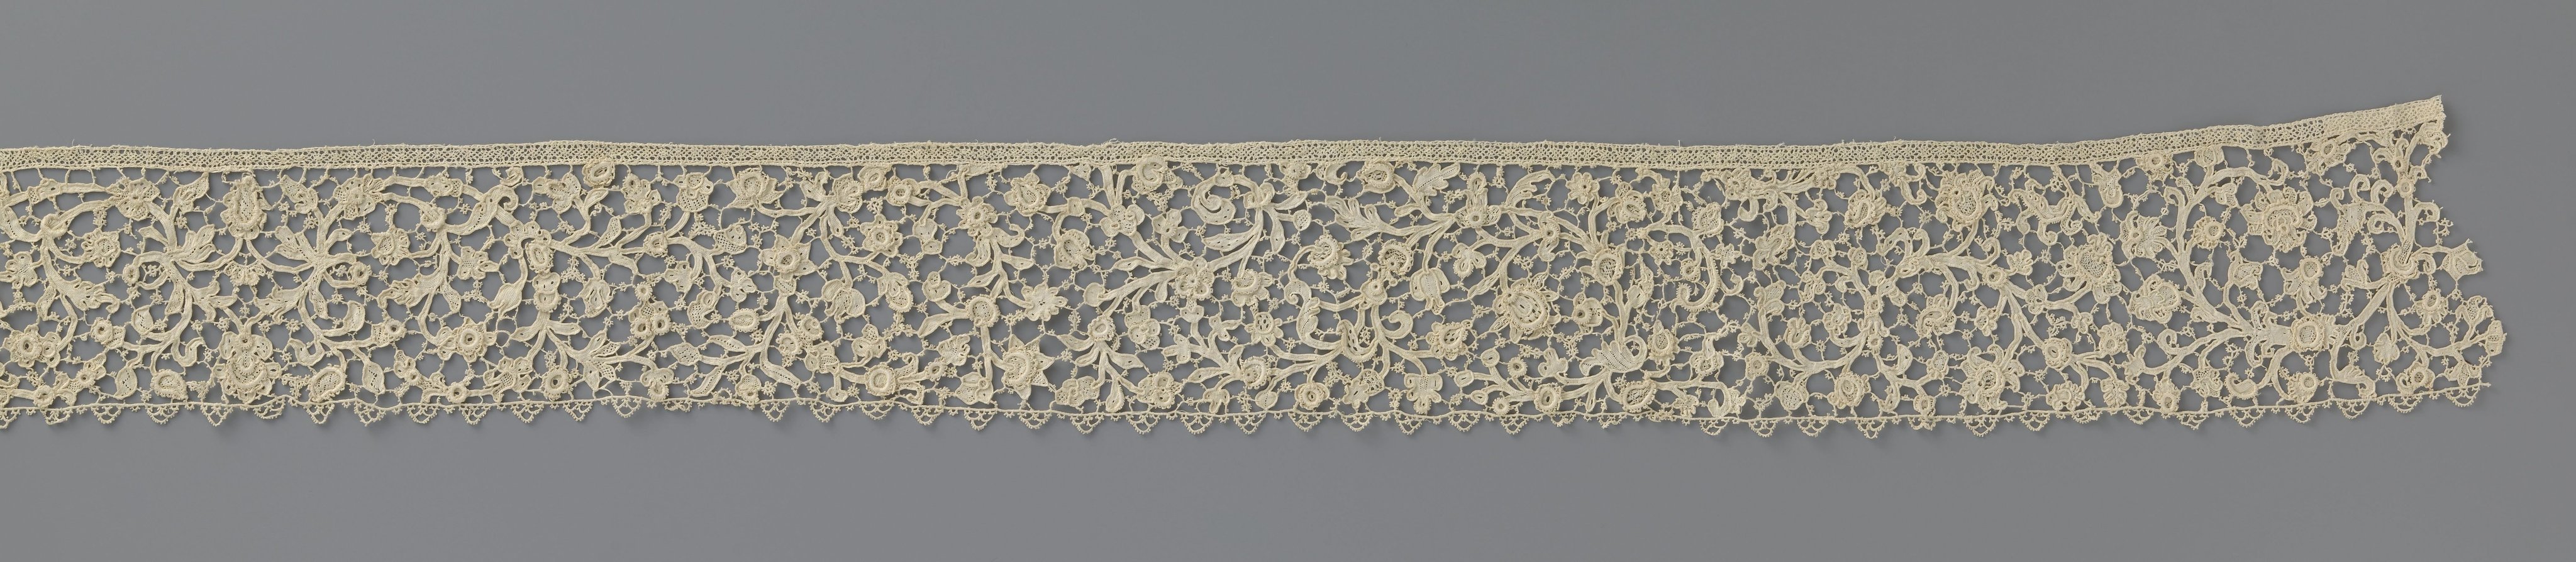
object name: strip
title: Strook naaldkant met veelsoortige bloemen en bladeren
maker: Anonymous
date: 1690-1709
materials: linen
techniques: rose point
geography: venice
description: Strook naturelkleurig naaldkant, Venetiaanse rozenkant. Patroon met ranken waaraan veelsoortige bloemen en bladeren zijn te zien, zonder repetitief motief. Onregelmatige open grond met gepicoteerde spijlen. De bovenzijde is afgezet met een rand kloskant. De onderzijde is afgewerkt met een rechte picotrand met boogjes.